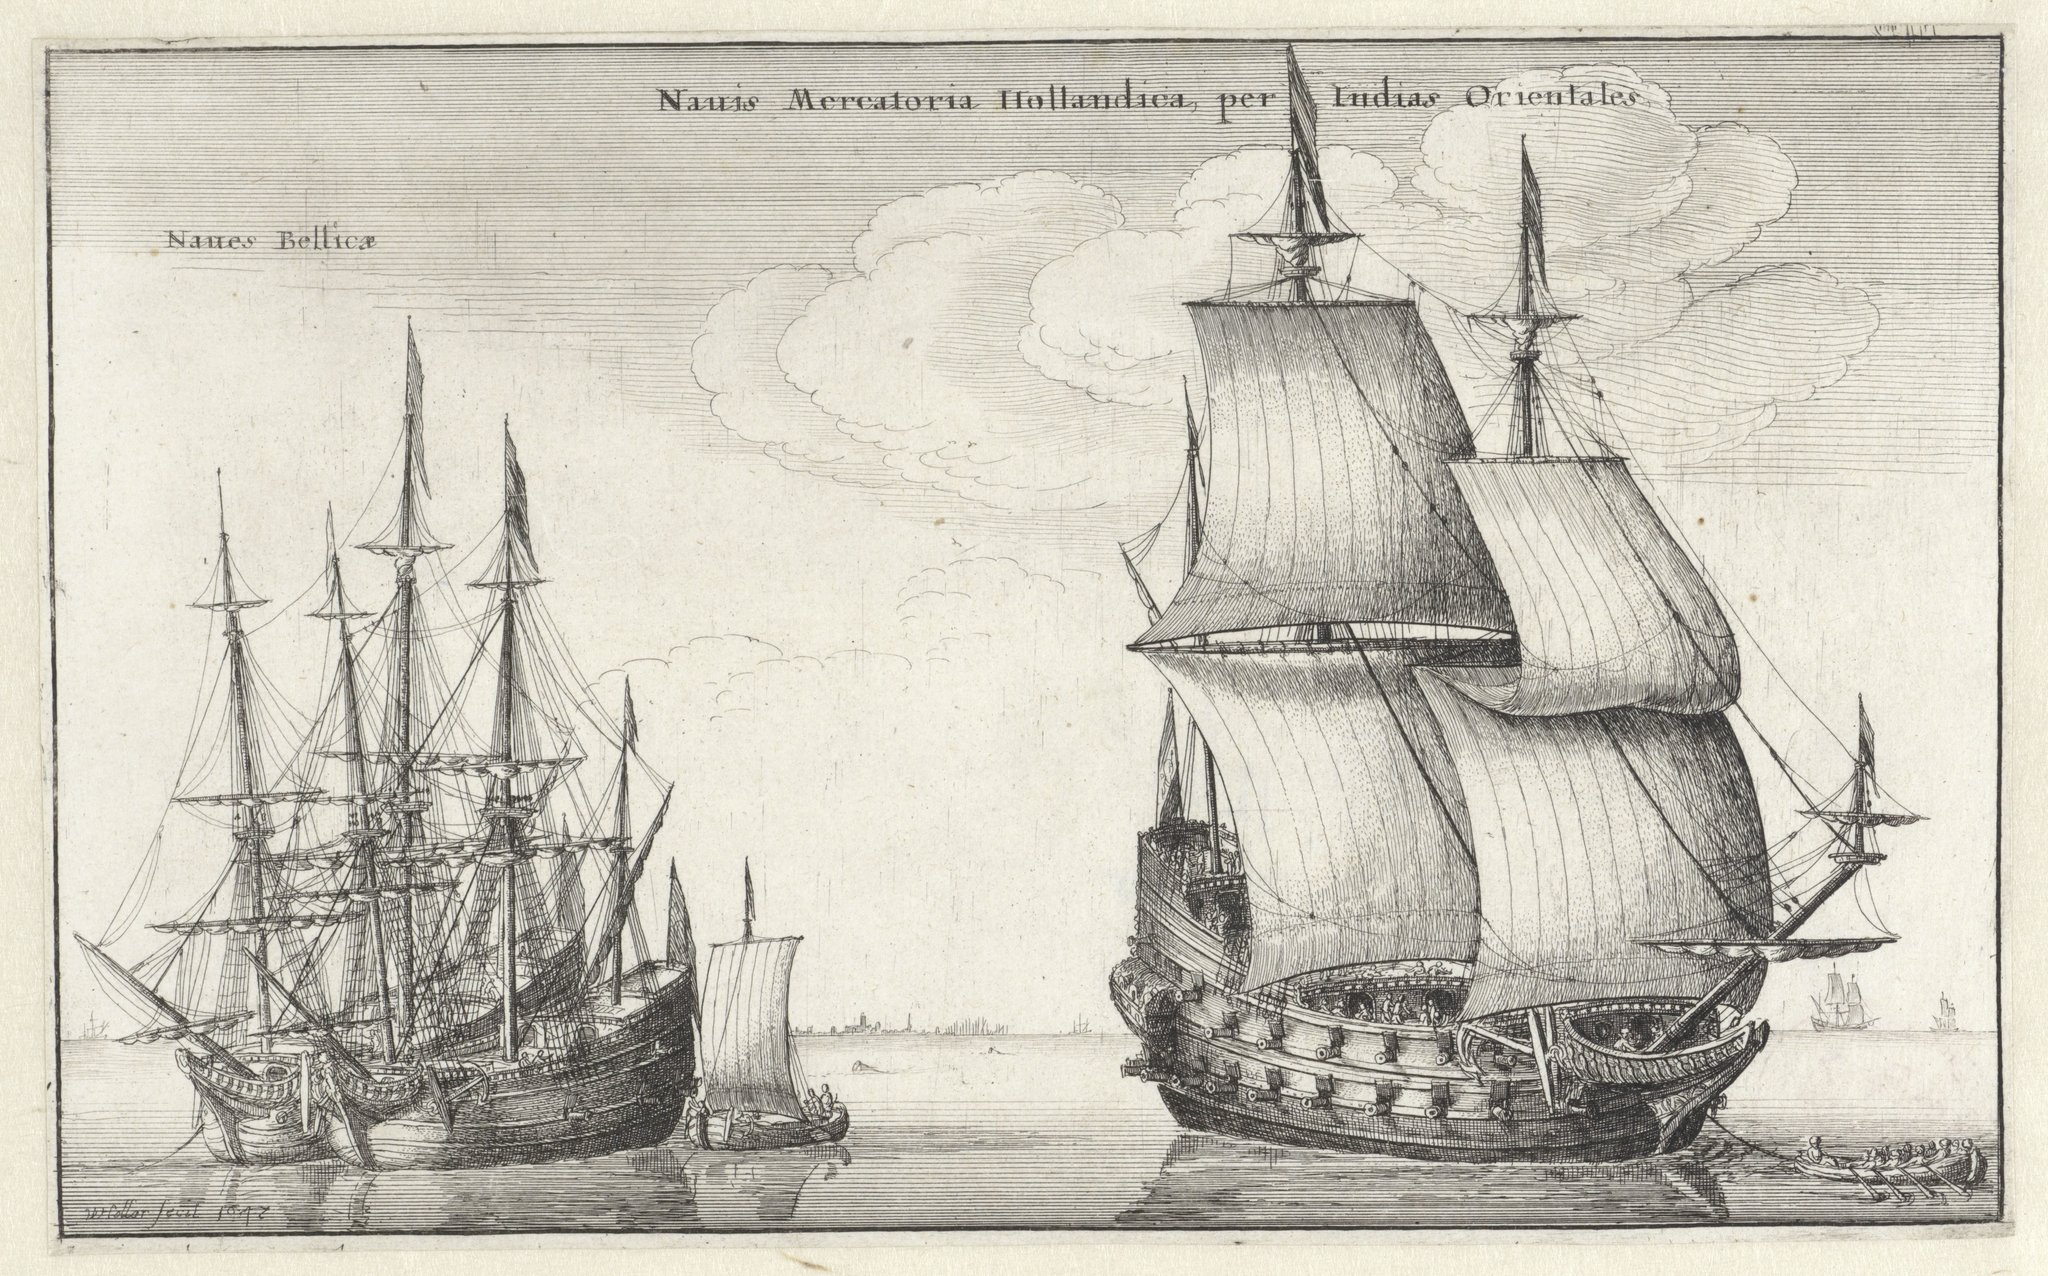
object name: print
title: Navis Mercatoria Hollandica, per Indias Orientales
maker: wenceslaus hollar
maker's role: draughtsman, print maker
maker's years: 1607-1677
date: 1647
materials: paper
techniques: etching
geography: antwerp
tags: sailing-ship, sailing-boat (westindiaman)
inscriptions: collector's mark: Lugt 240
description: De prent maakt deel uit van de twaalfdelige serie "Navium Variae Figurae".